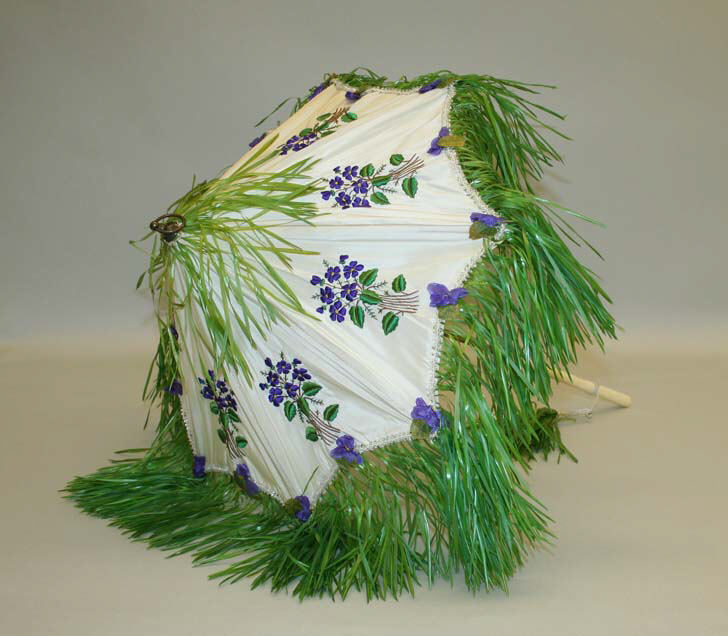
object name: parasol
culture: french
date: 1860-1869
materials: ivory, metal, silk, fiber